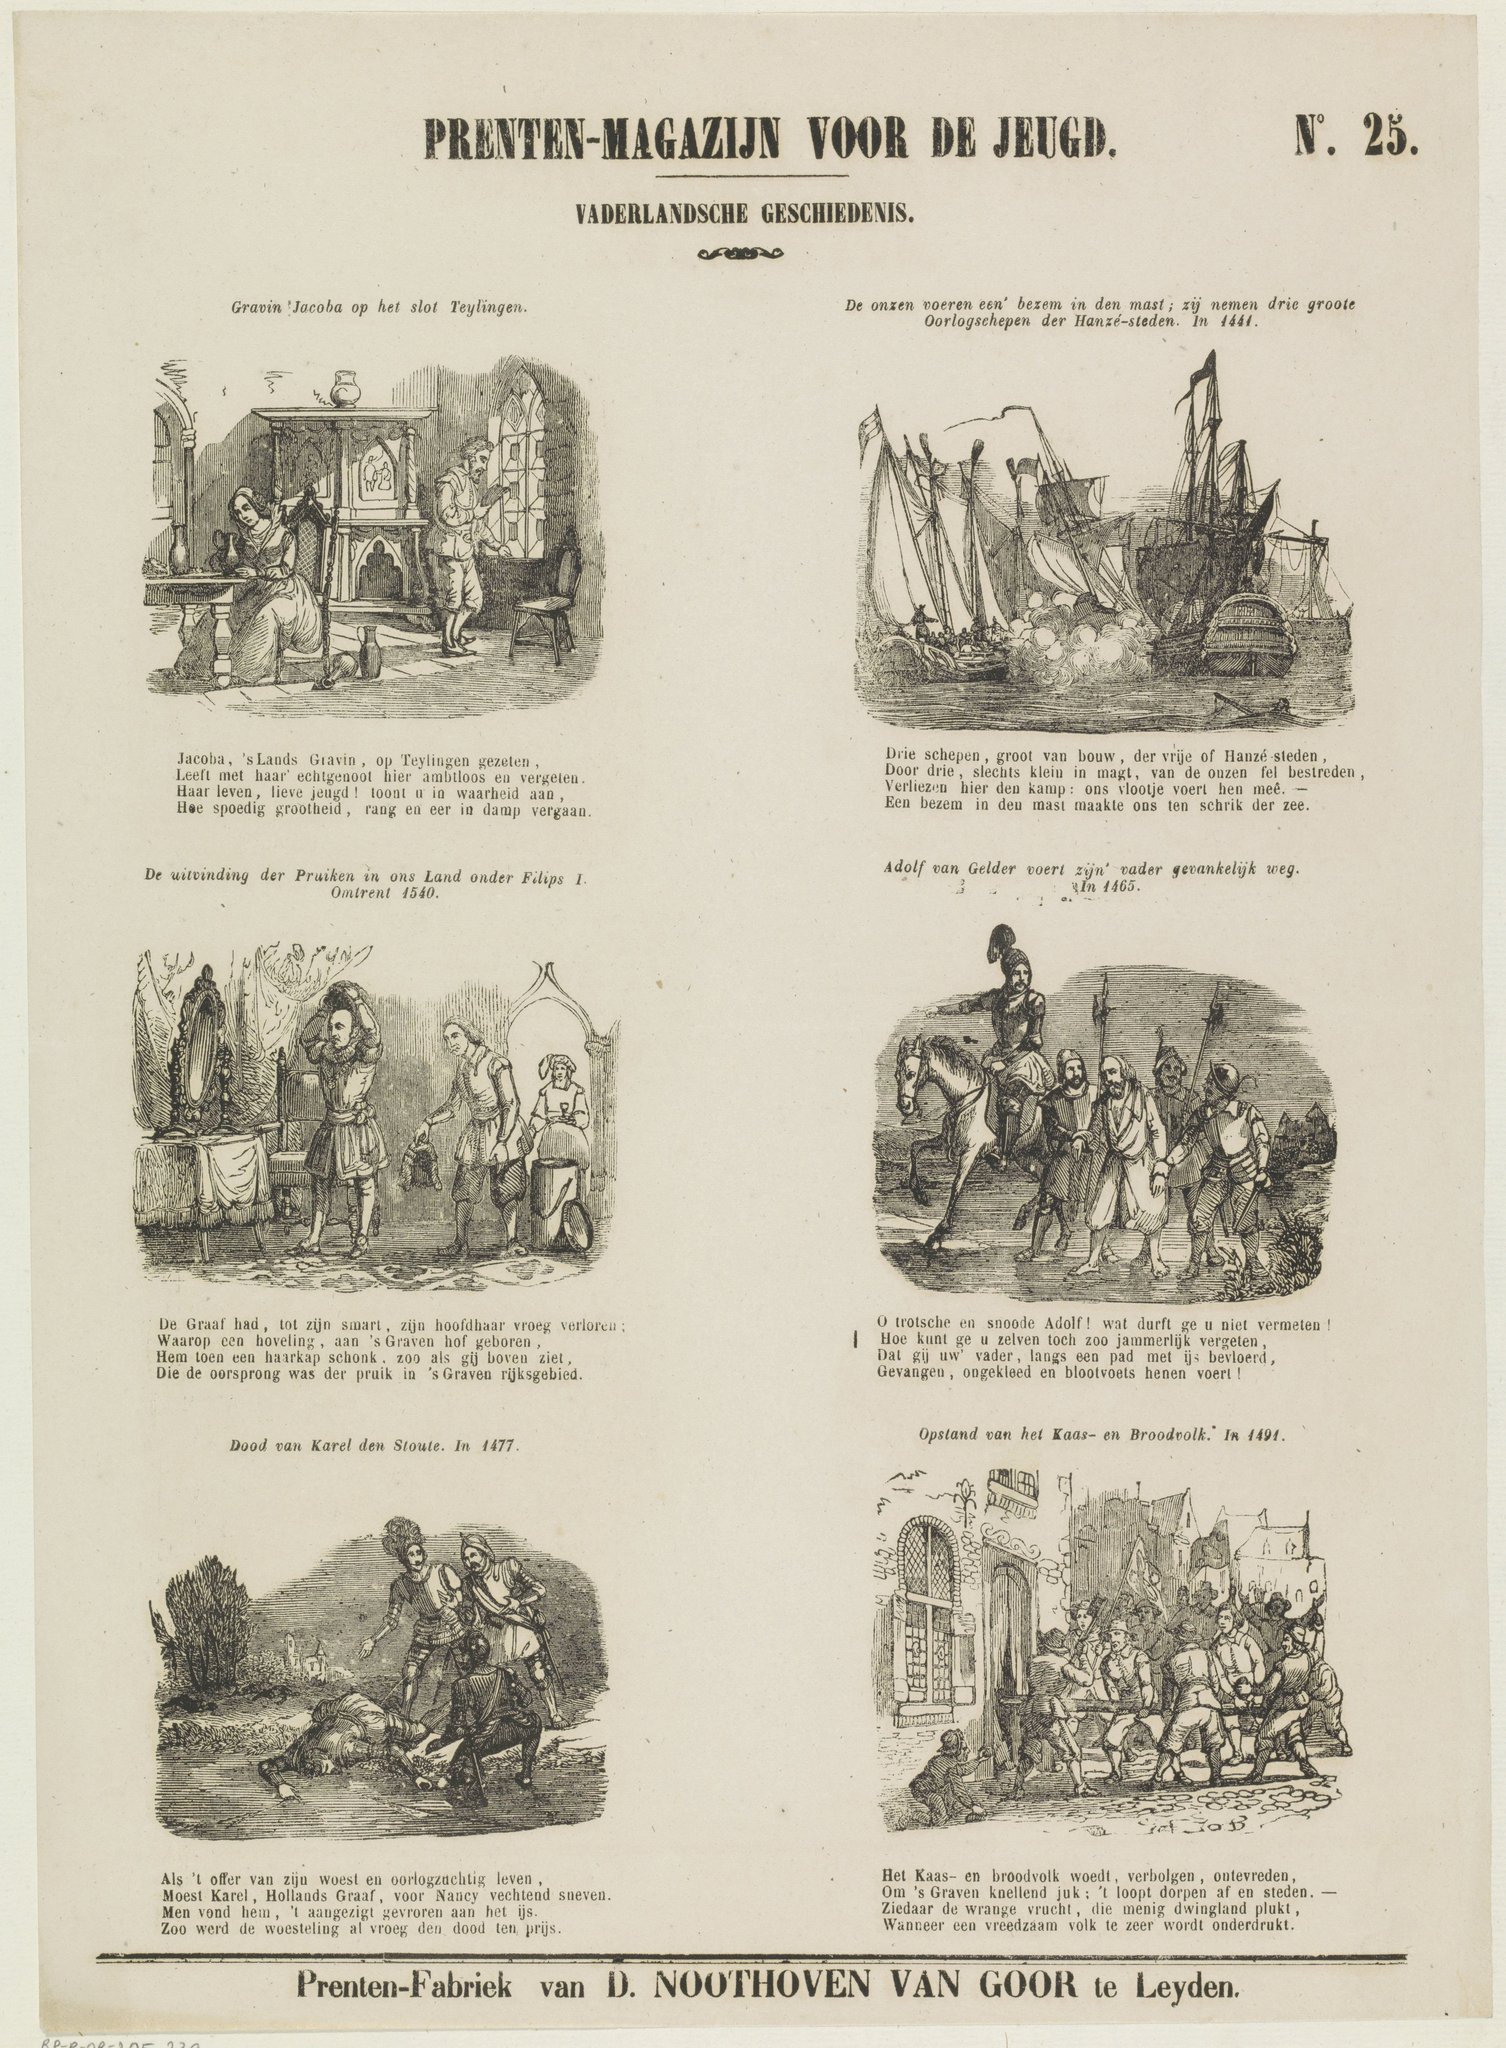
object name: popular print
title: Prenten-magazijn voor de jeugd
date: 1850-1881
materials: paper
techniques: letterpress printing, engraving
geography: leiden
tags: jacoba of bavaria (countess of hainaut), earl, charles the bold (duke of burgundy), military vehicles (+ sailing-ships), wig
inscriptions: collector's mark: Lugt 2760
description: Blad met 6 voorstellingen van gebeurtenissen uit de vaderlandse geschiedenis. Boven elke voorstelling een titel en onder elke voorstelling een vierregelig vers. Genummerd rechtsboven: No. 25.